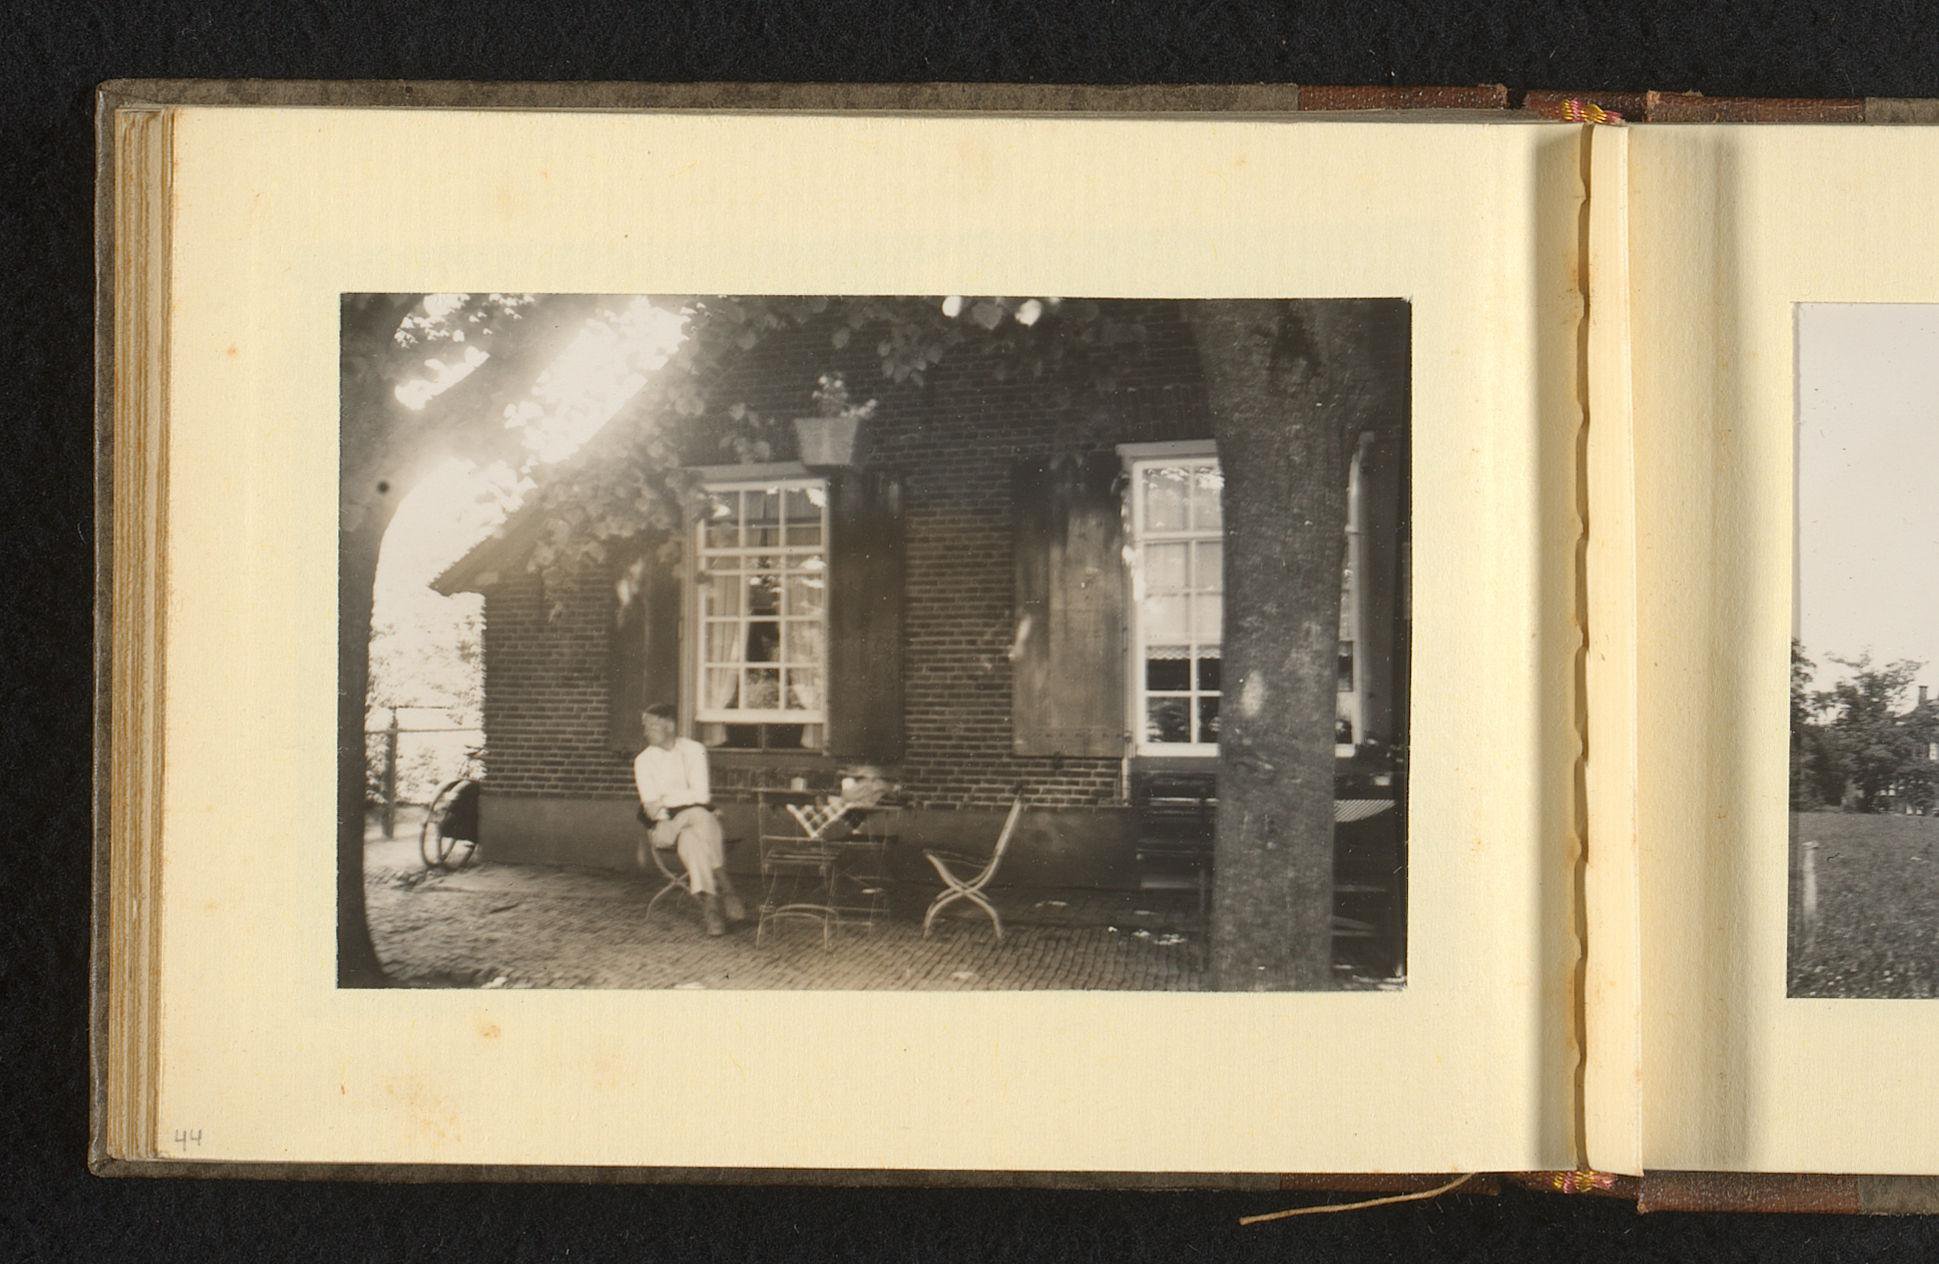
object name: photograph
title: Man op een terras voor een woning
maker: norbert van den berg (1901-1972)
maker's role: amateurfotograaf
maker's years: 1901-1972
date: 1935-1950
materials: paper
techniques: gelatin silver print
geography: netherlands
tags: adult man, terrace, façade (of house or building)